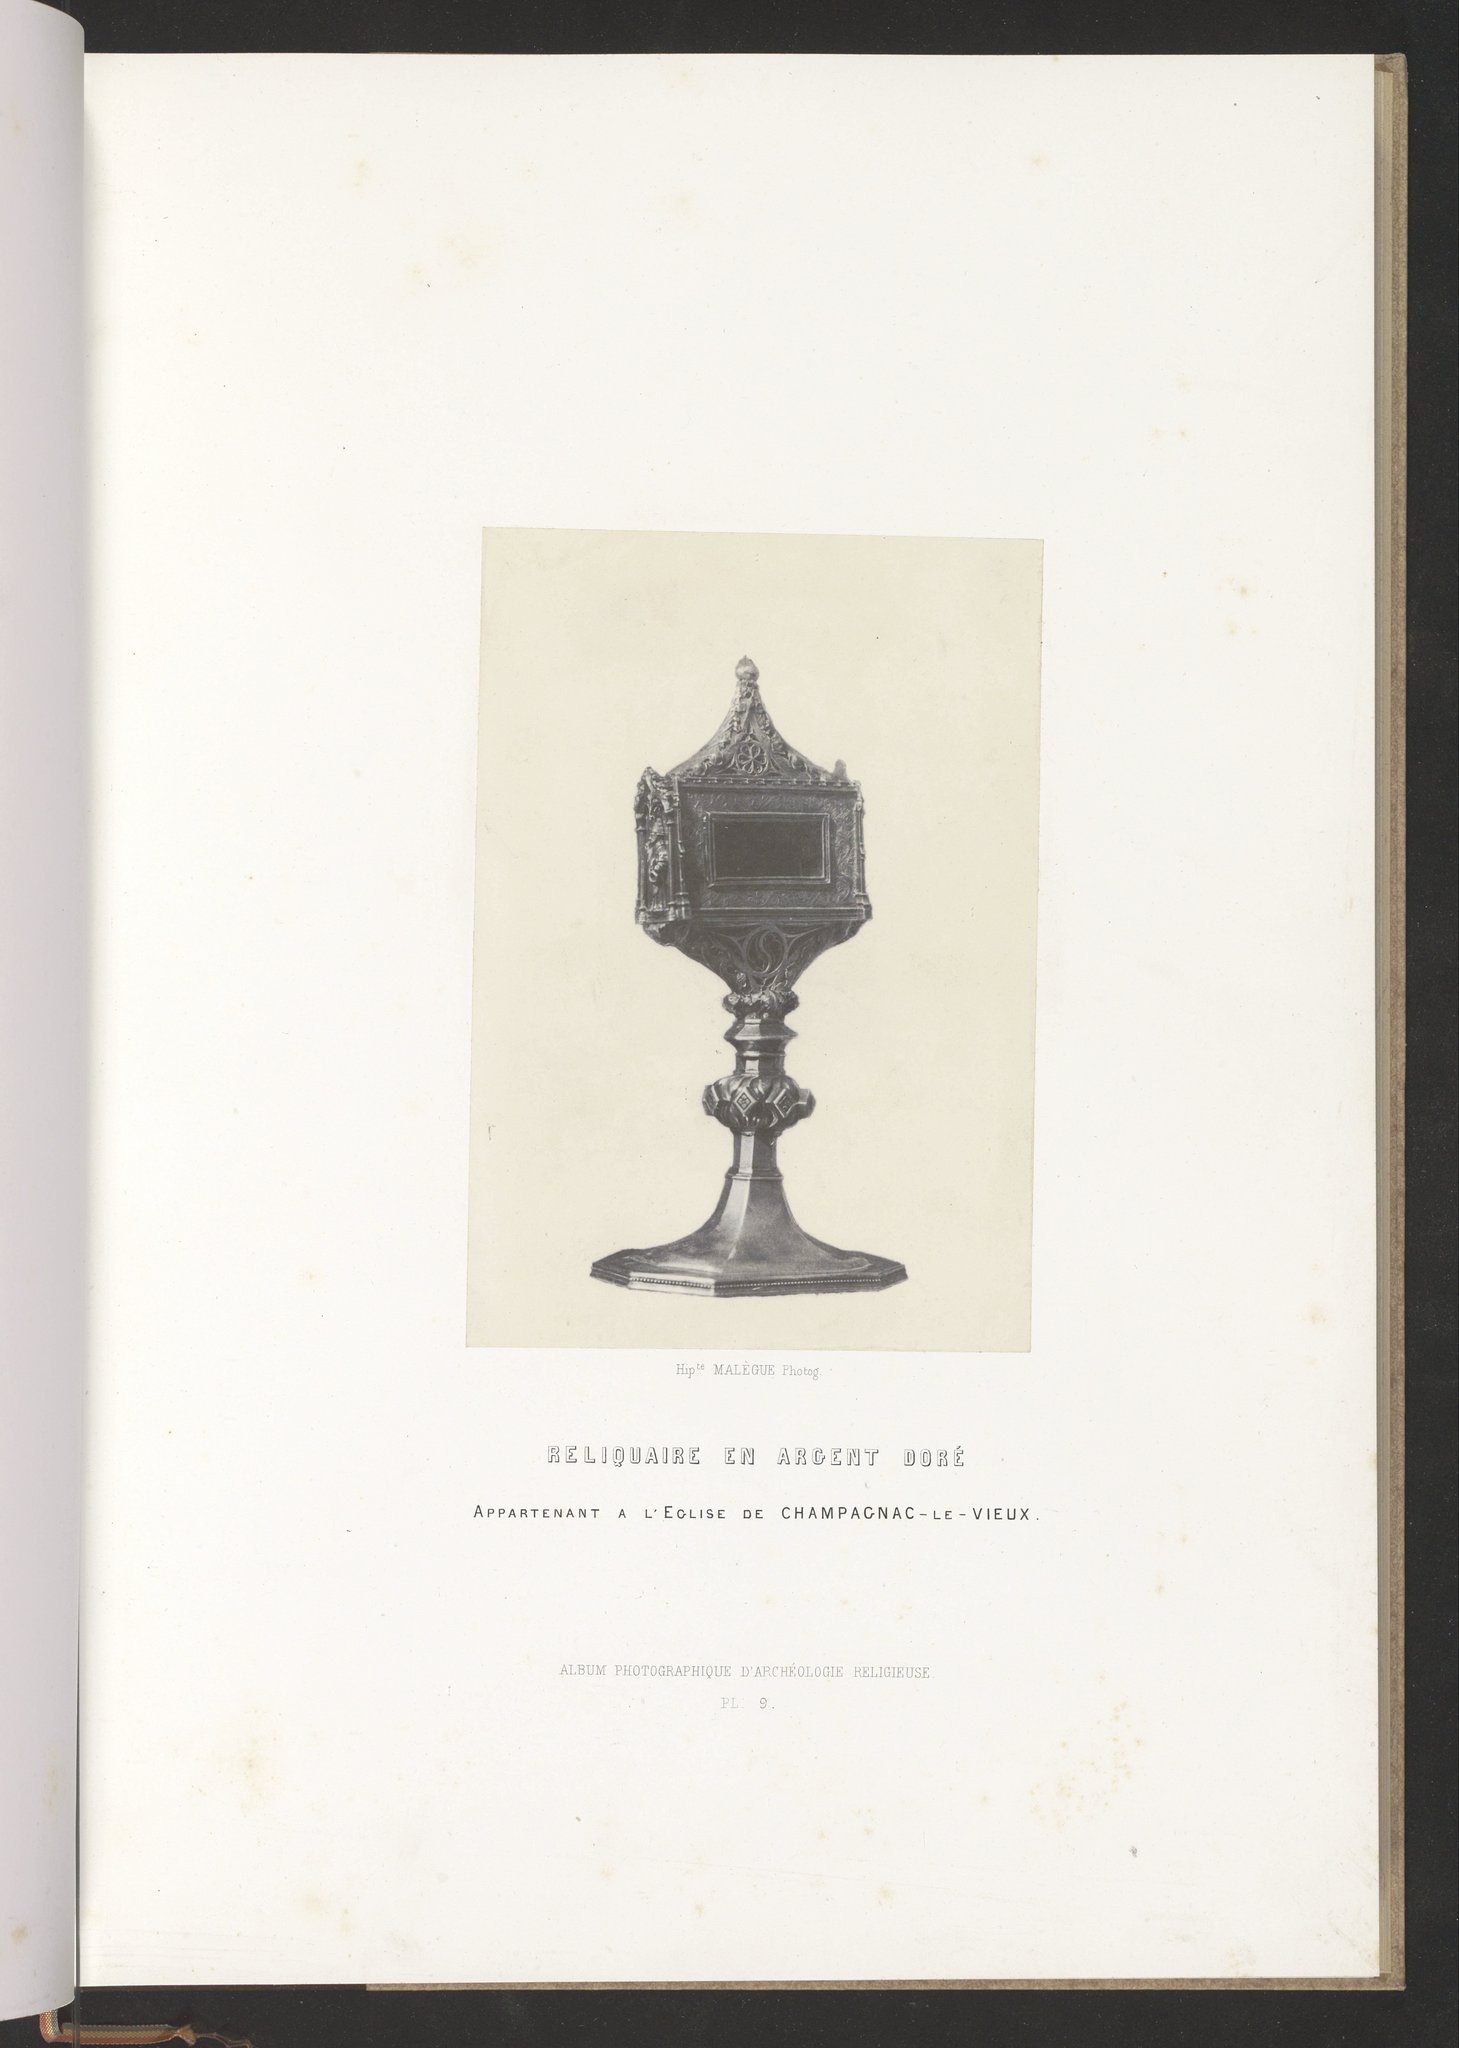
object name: page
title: Zilveren reliekhouder afkomstig uit de kerk Saint-Pierre te Champagnac-le-Vieux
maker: hippolyte malègue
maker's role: archeoloog, fotograaf, schrijver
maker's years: 1825-1901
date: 1850-1857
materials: photographic support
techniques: salted paper print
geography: france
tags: relics (and reliquaries)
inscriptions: number: ‘PL. 9.’, inscription: ‘appartenant a l'eglise de Champagnax-le-Vieux.’